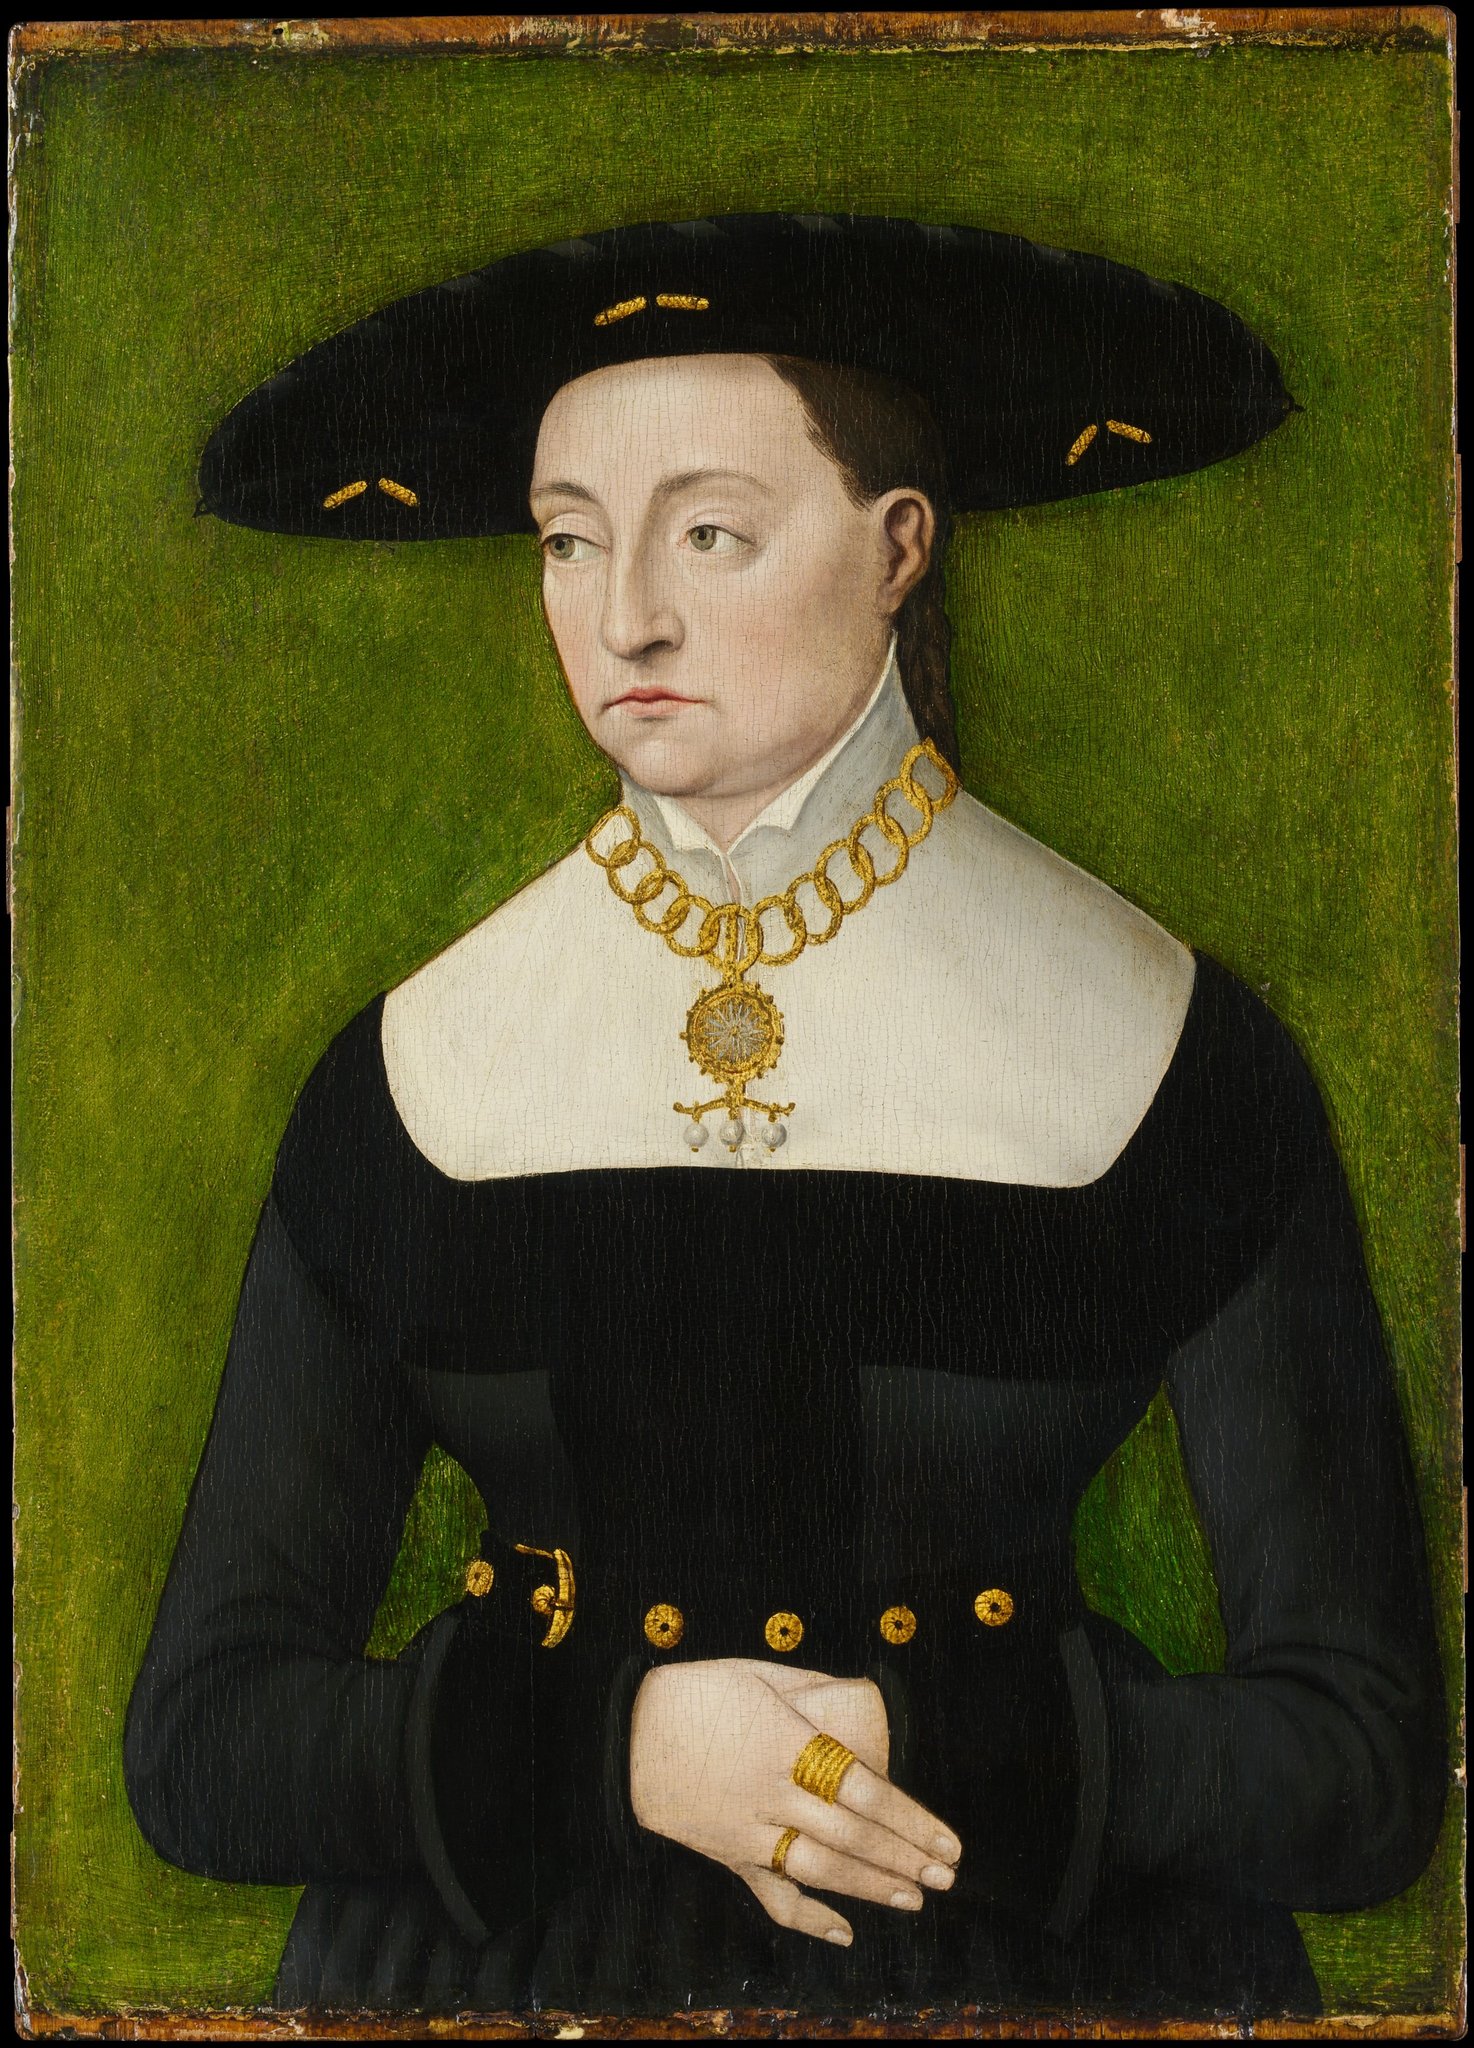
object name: painting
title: Katharina Merian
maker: hans brosamer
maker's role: artist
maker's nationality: german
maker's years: 1536-1552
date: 1536-1552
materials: gold, wood, metal, oil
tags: portraits,women